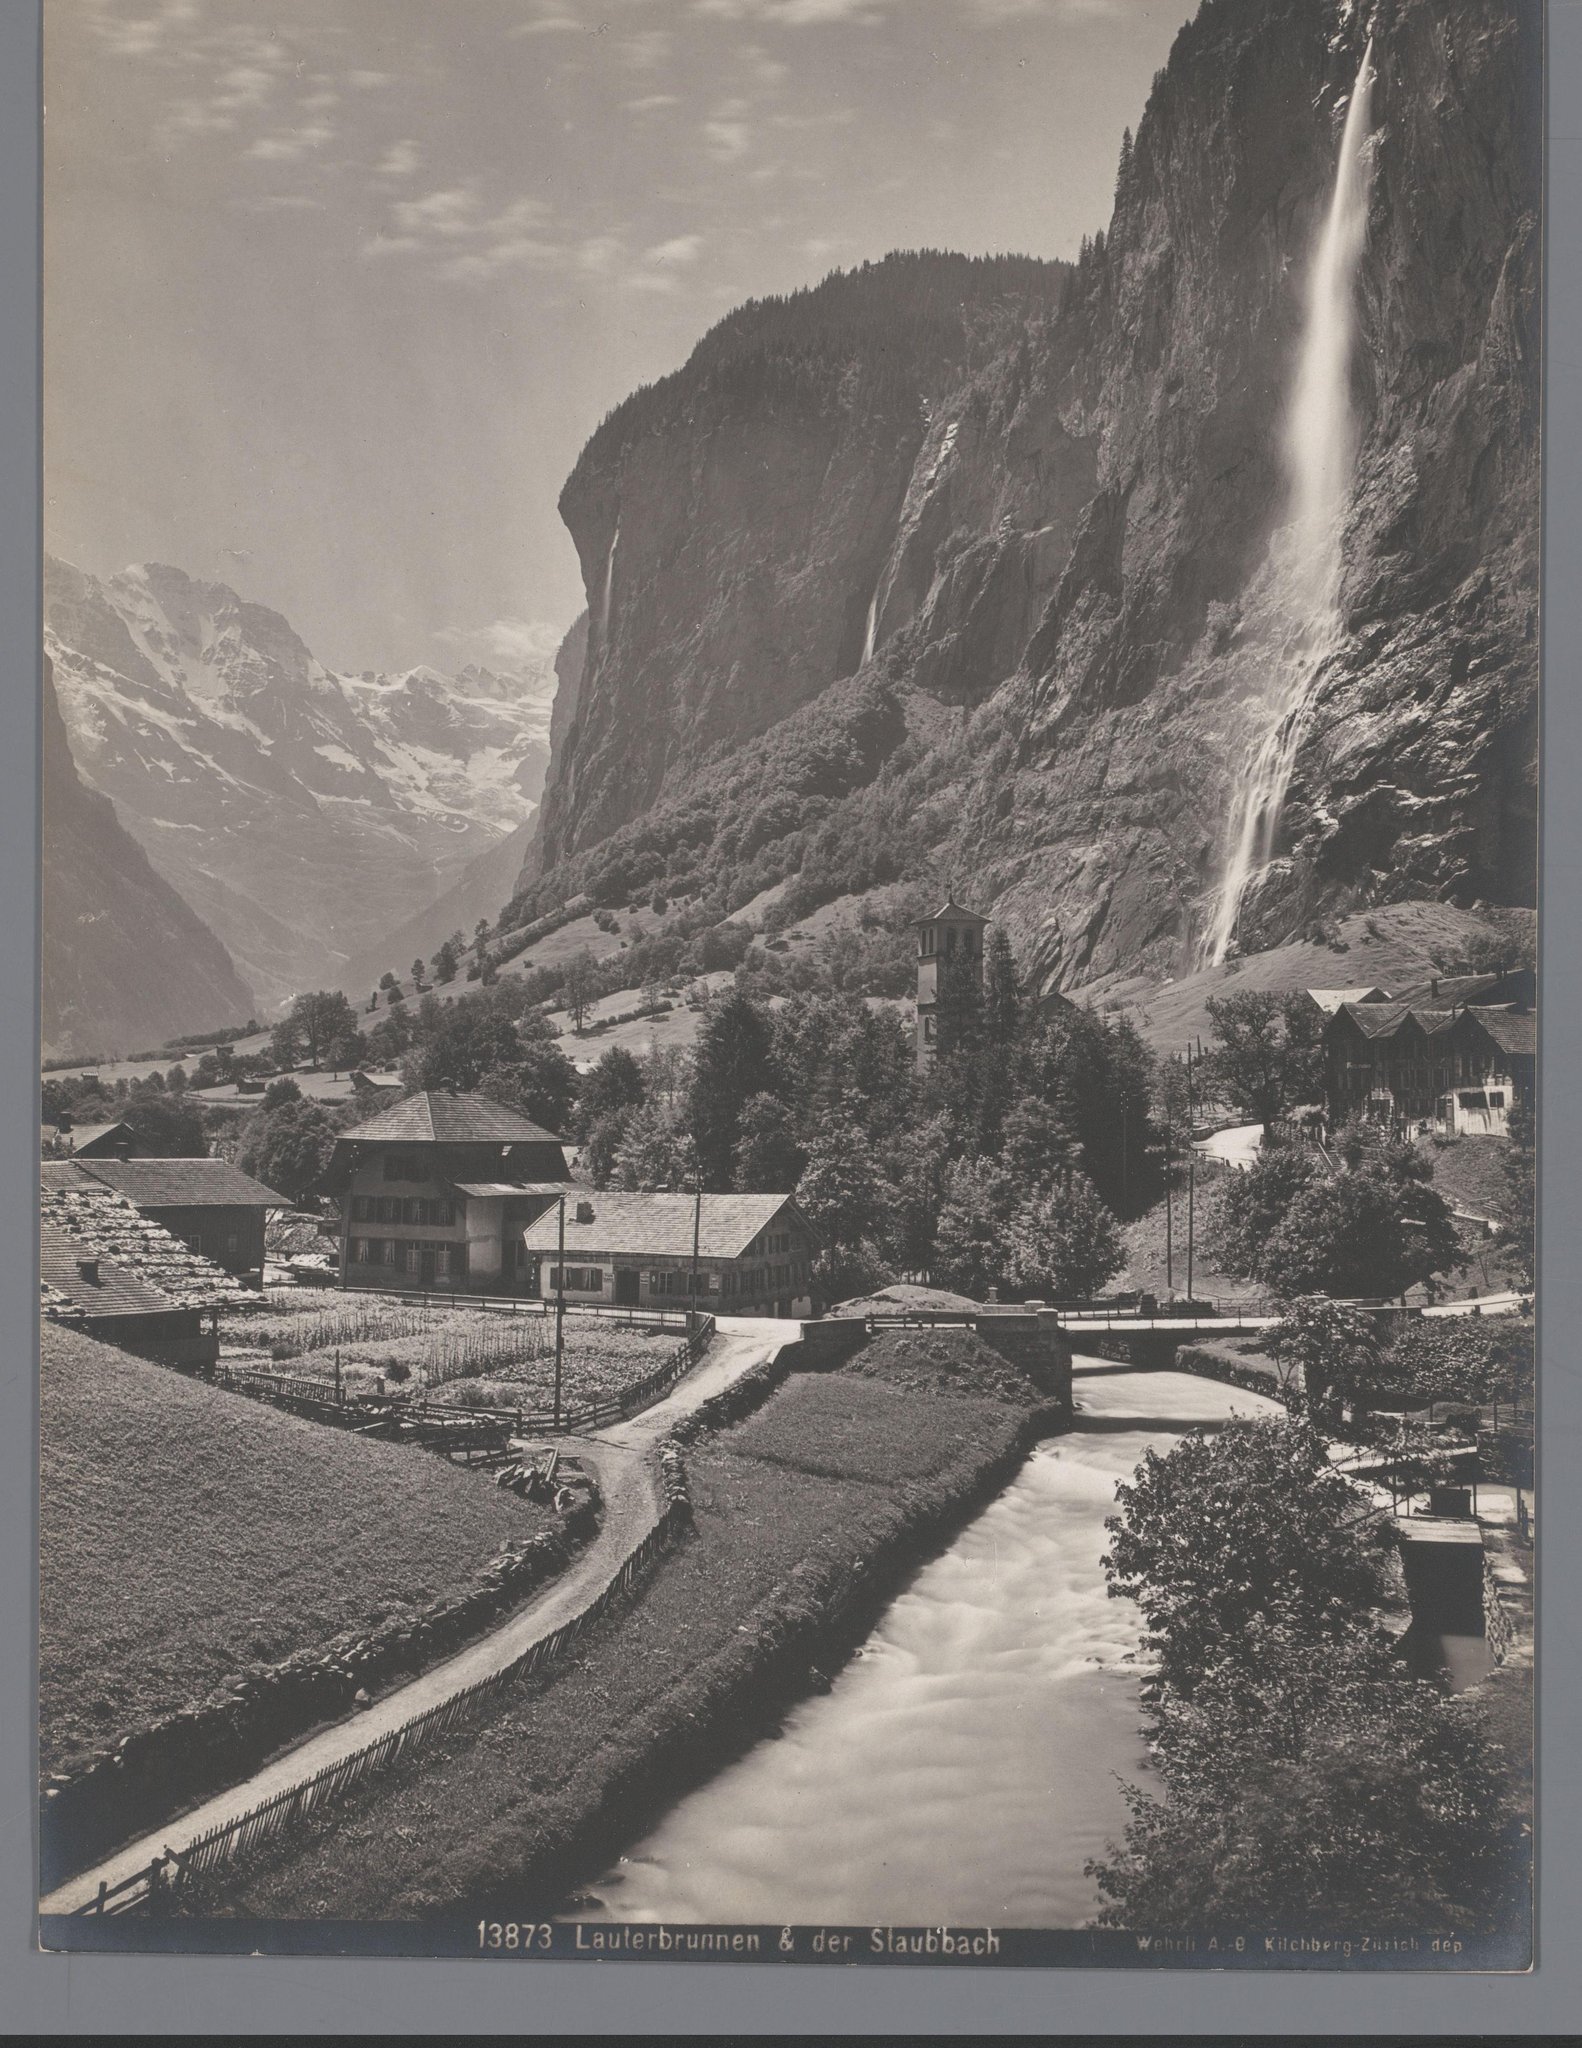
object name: photograph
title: De plaats Lauterbrunnen en de Staubbach-waterval, Berner Oberland, Zwitserland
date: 1890-1925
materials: cardboard, paper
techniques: gelatin silver print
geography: switzerland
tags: lauterbrunnen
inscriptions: inscription: ‘Wehrli A.G. Kilchberg - Zürich dép.’, inscription: ‘13873 Lauterbrunnen & der Staubbach’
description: De plaats Lauterbrunnen en rechts de Staubbach: deze waterval is met een hoogte van 300 m hoogte een van de hoogste van Europa.